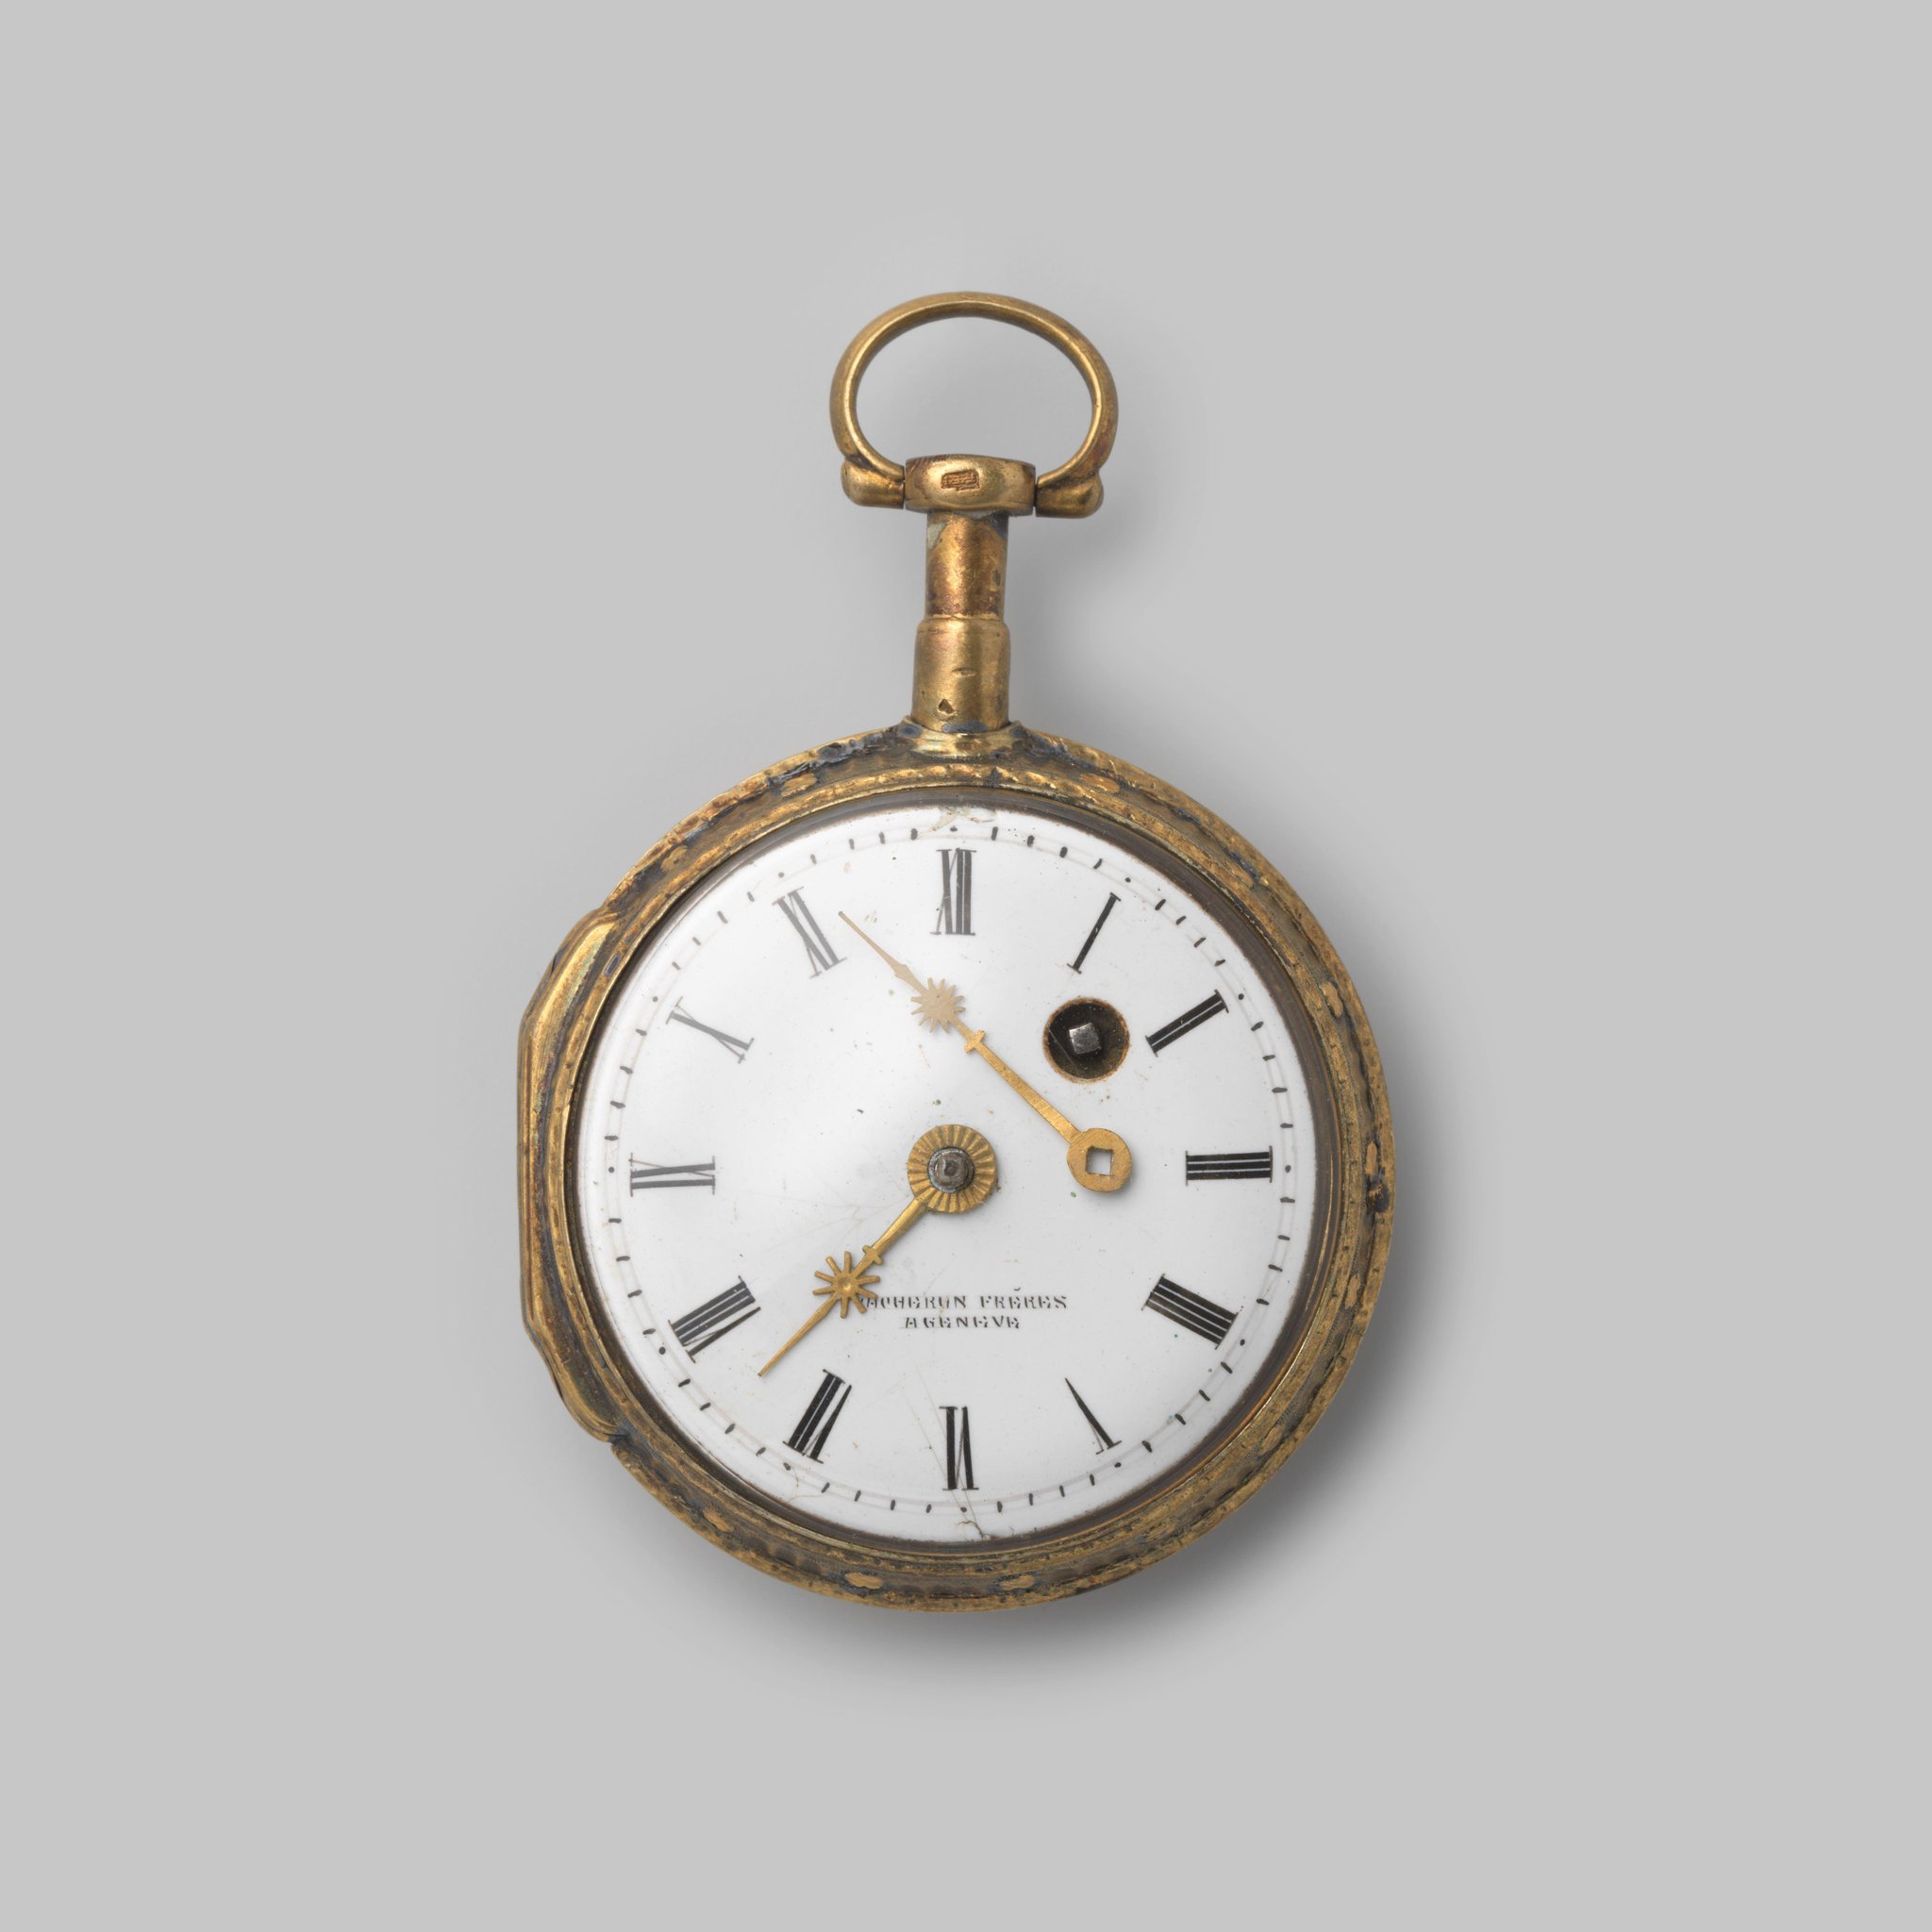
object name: forgery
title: Horloge van goud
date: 1800-1900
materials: gold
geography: geneva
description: Gouden horloge, met geëmailleerde wijzerplaat. Op de achterbodem in een ovaal een portret van een gemaskerde vrouw. De kast is vals.